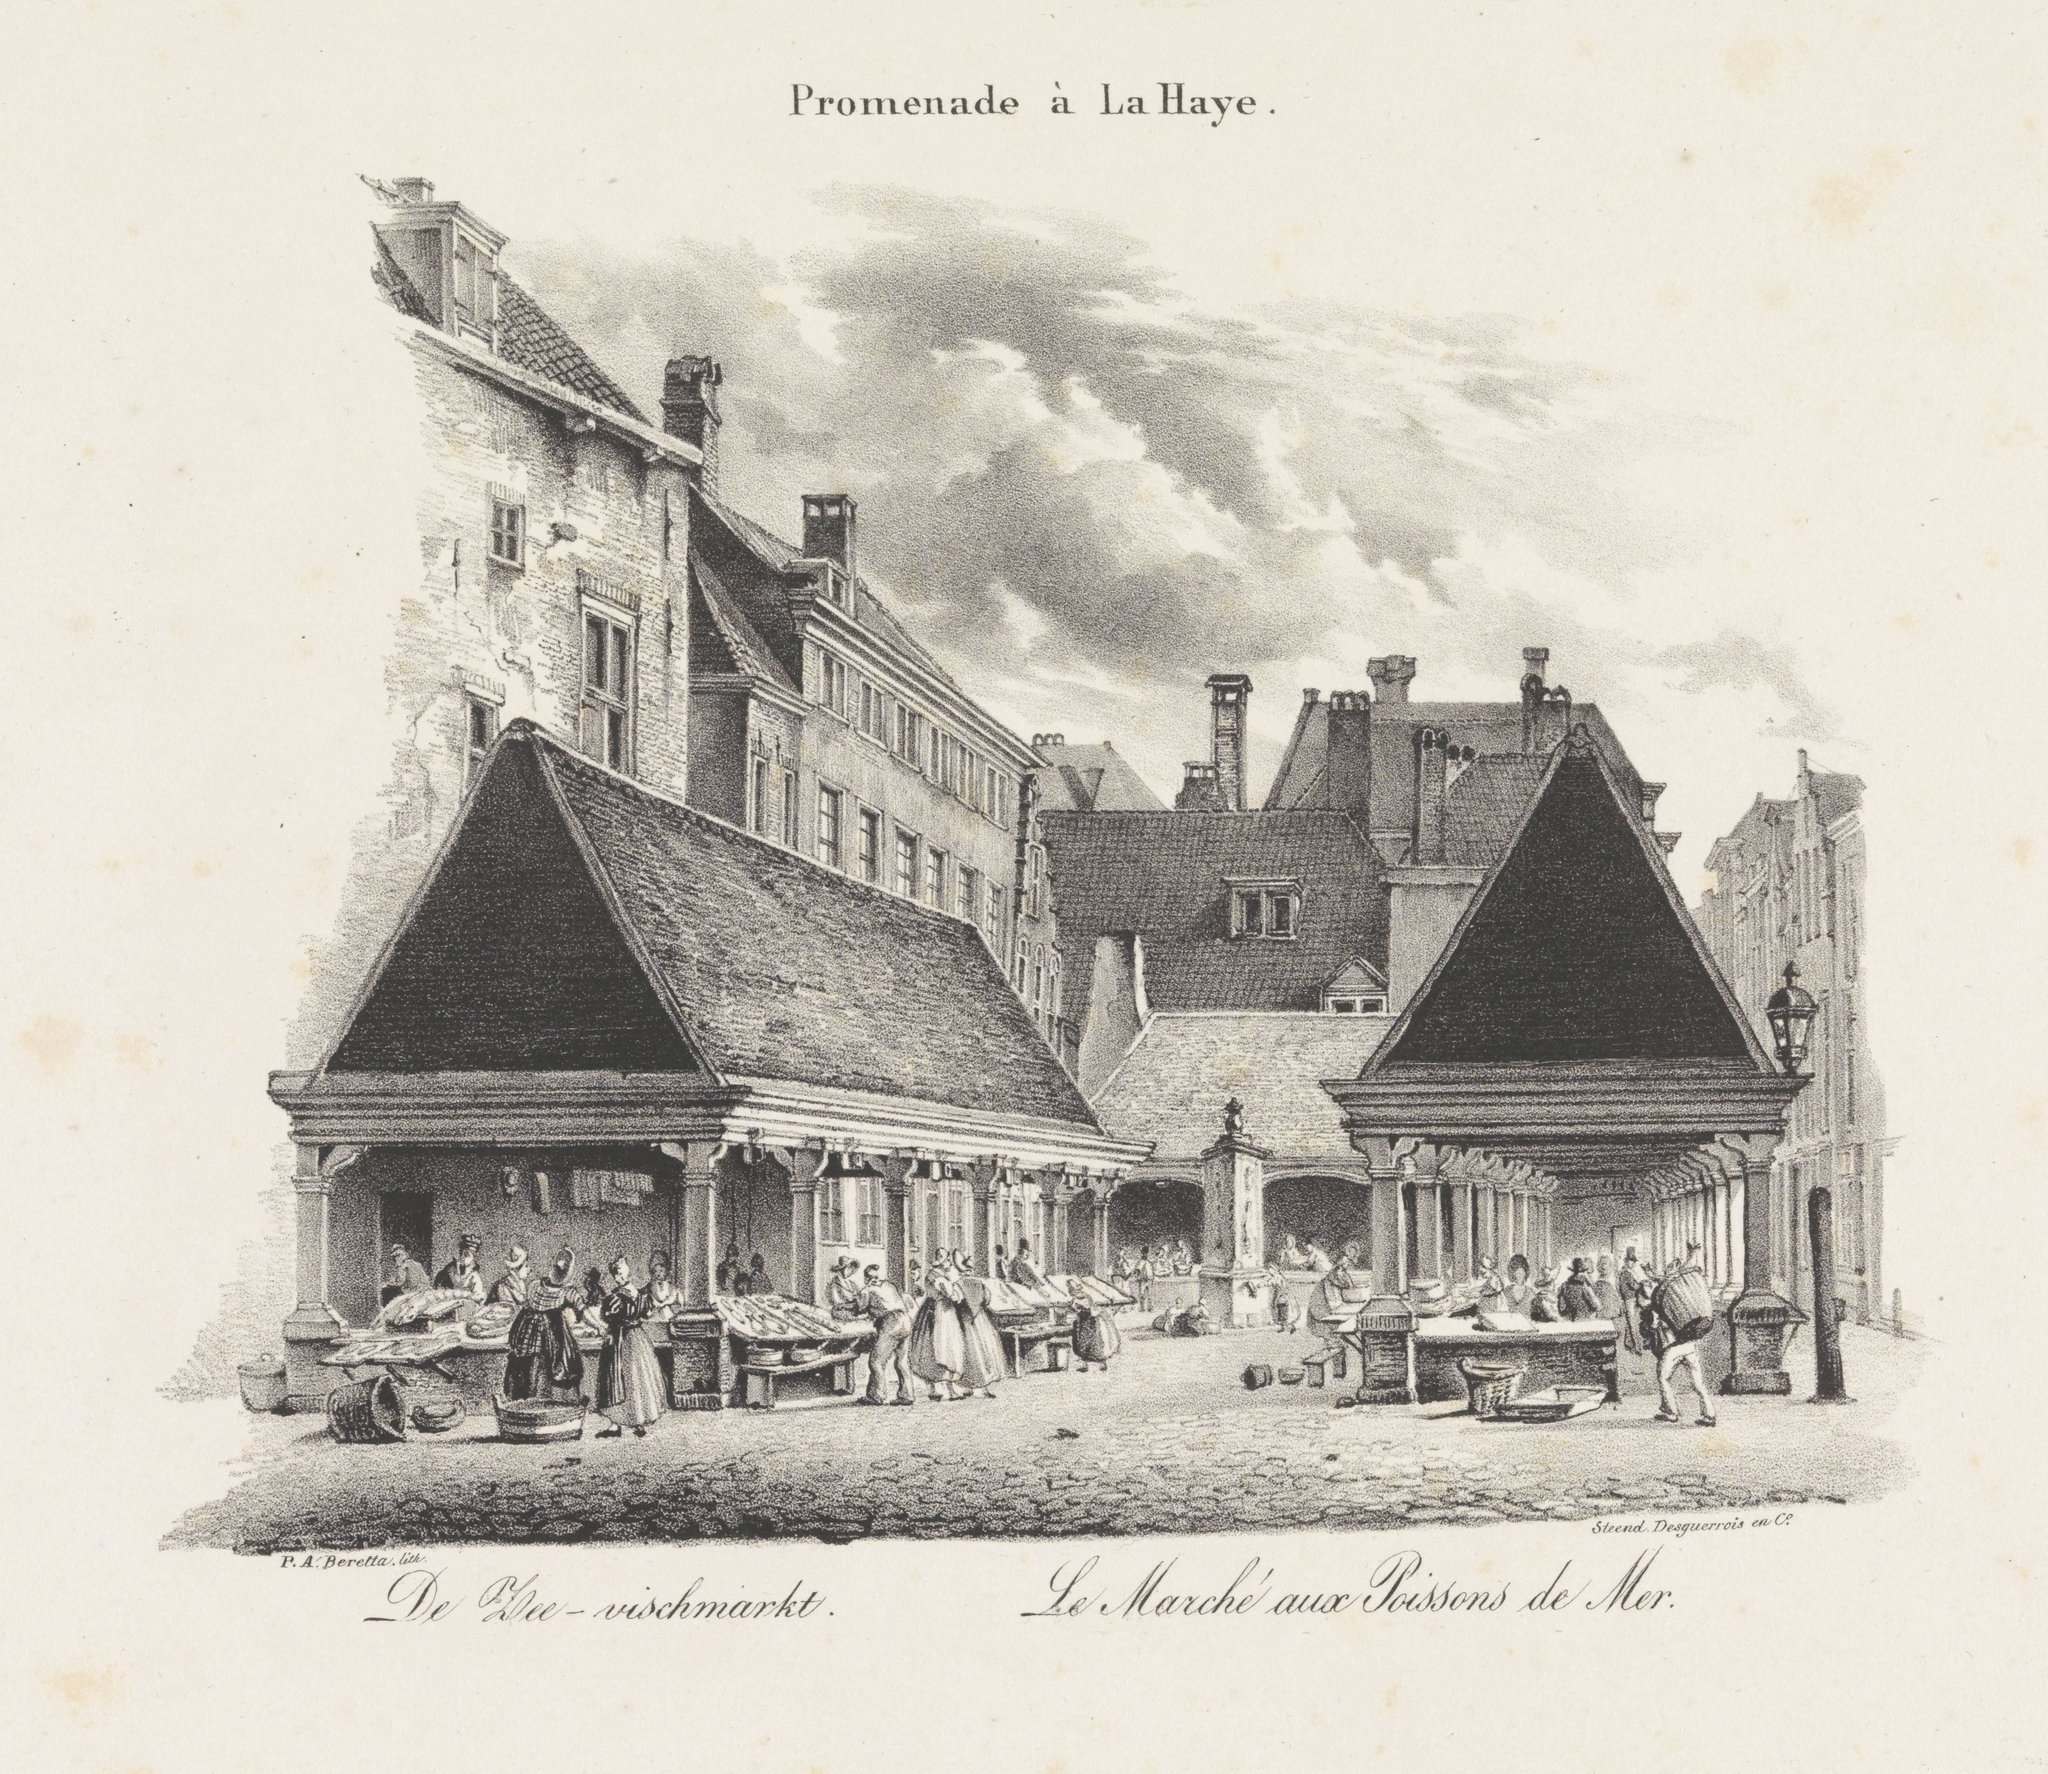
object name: print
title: Une promenade dans la Haye et ses environs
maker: petrus augustus beretta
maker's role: draughtsman, print maker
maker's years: 1805-1866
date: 1815-1866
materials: paper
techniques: lithograph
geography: netherlands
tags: fishes, market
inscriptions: collector's mark: Lugt 2228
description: Deze prent maakte deel uit van de uitgave: Une promenade dans la Haye et ses environs : vues dessinées d'après nature par C.C.A. Last et J.C. van Pappelendam, uitgegeven in 1833.